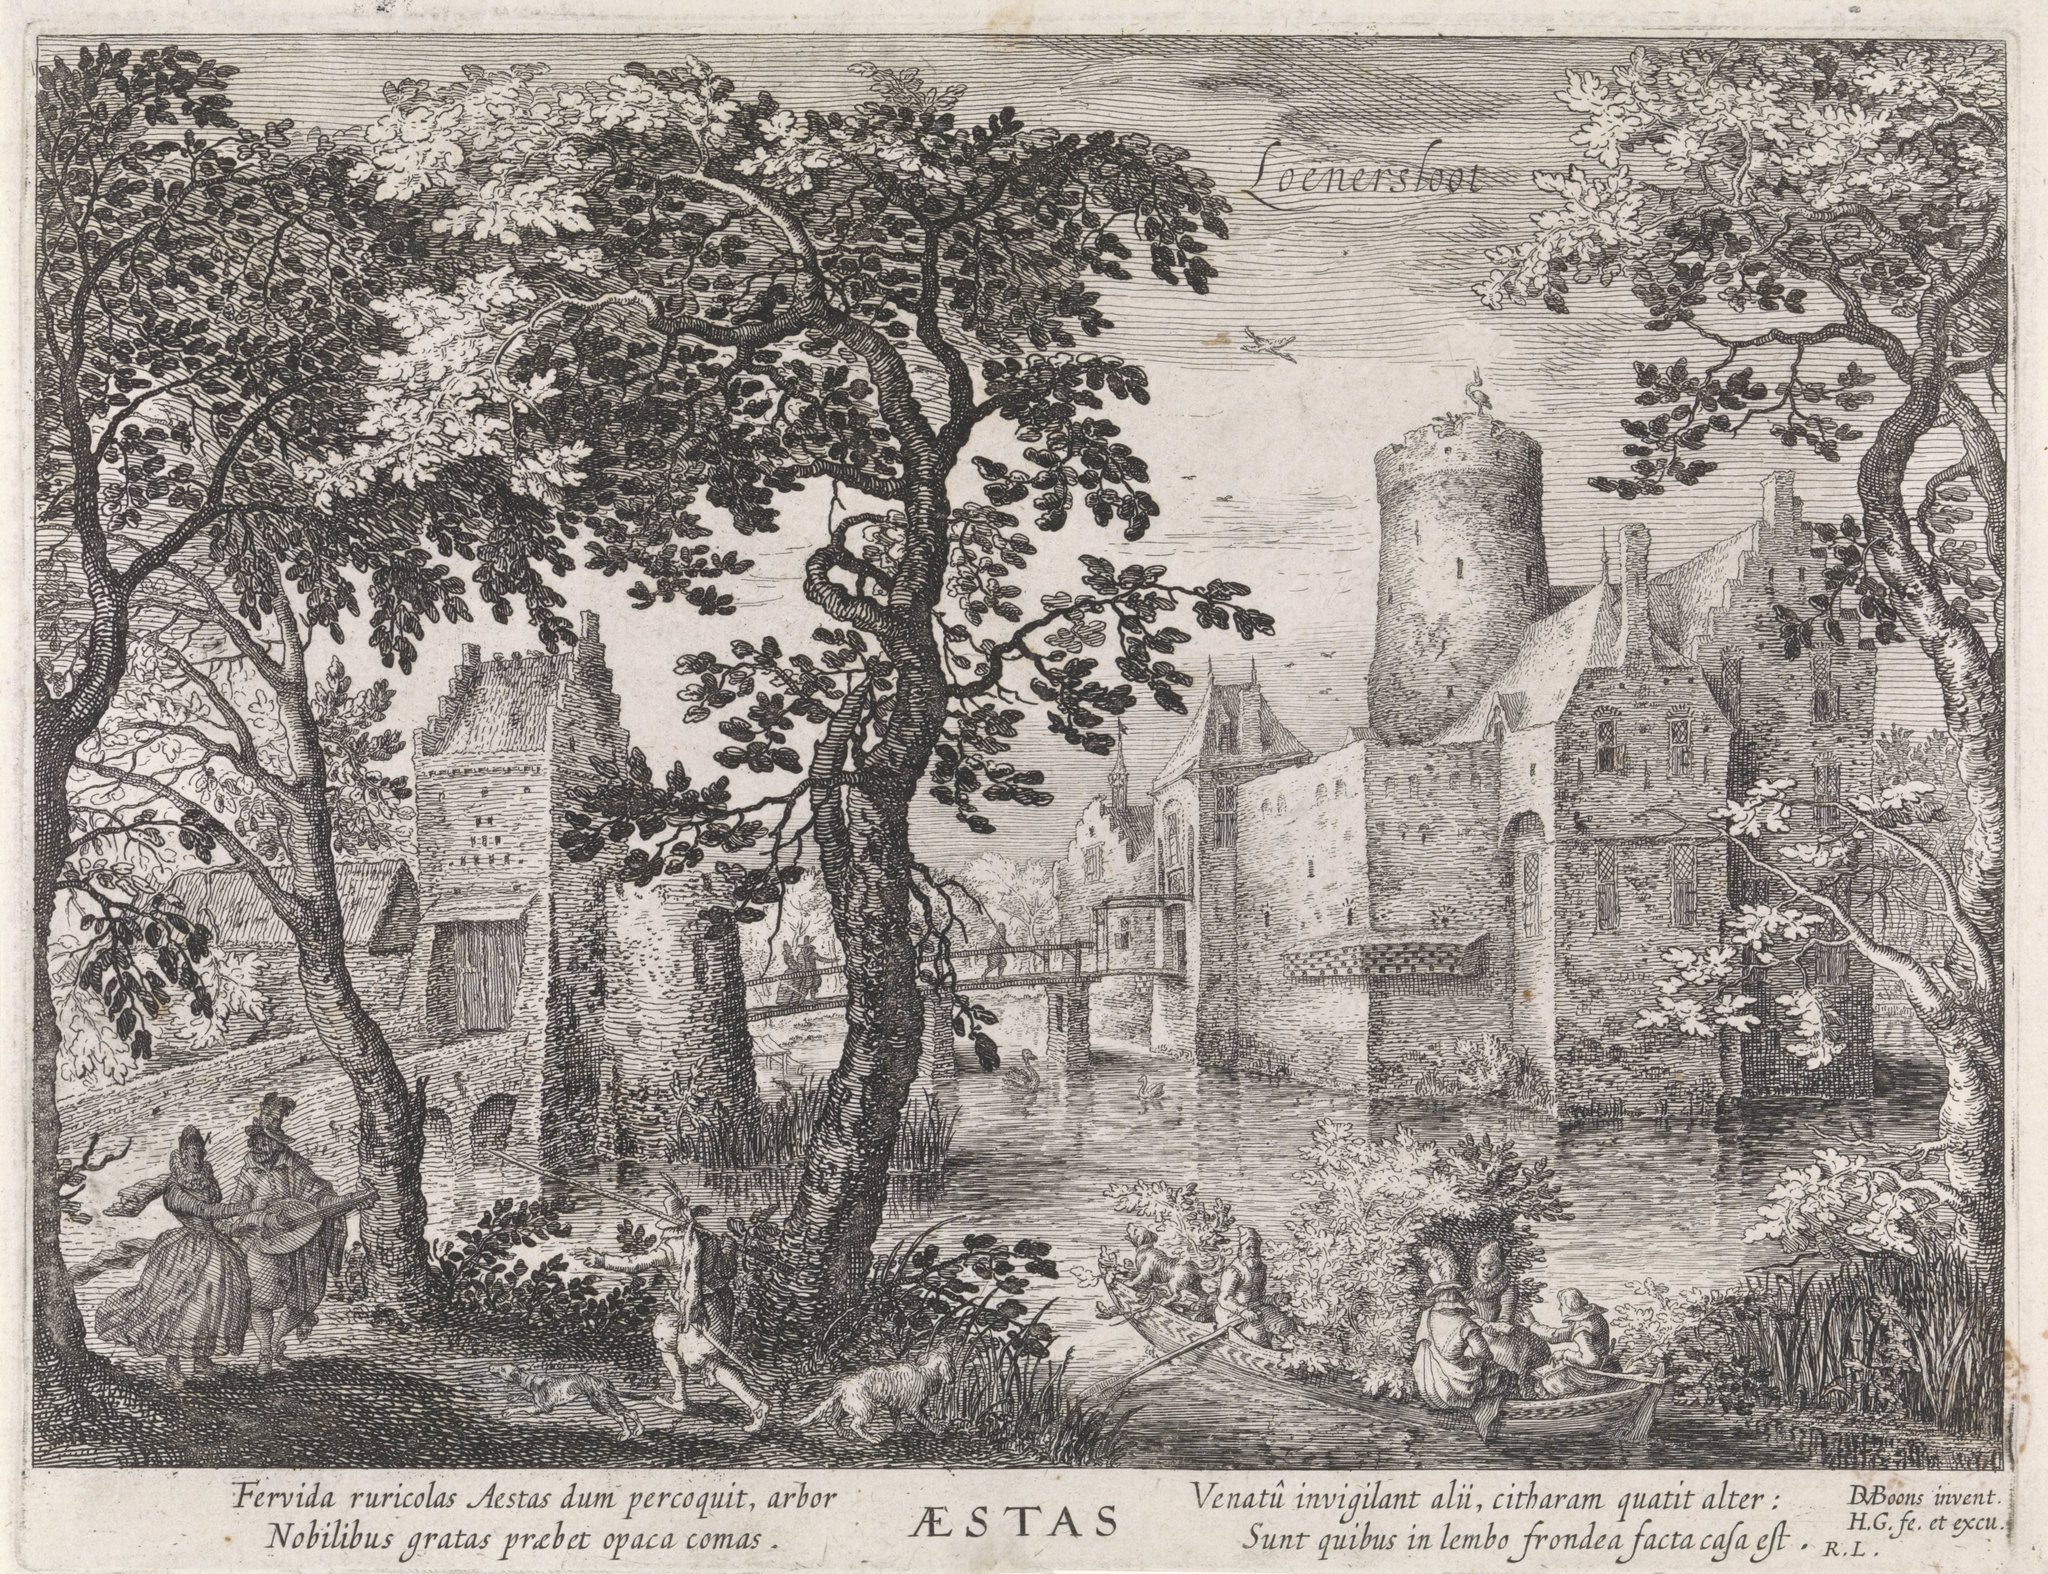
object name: print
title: Aestas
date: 1591-1632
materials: paper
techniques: etching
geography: amsterdam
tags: summer ~ human activities (the four seasons of the year)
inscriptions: collector's mark: Lugt 2228, collector's mark: Lugt 240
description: Het seizoen zomer. Een elegant gezelschap vermaakt zich in een bootje en met muziek bij kasteel Loenersloot. Met onderschrift van 4 regels in het Latijn.